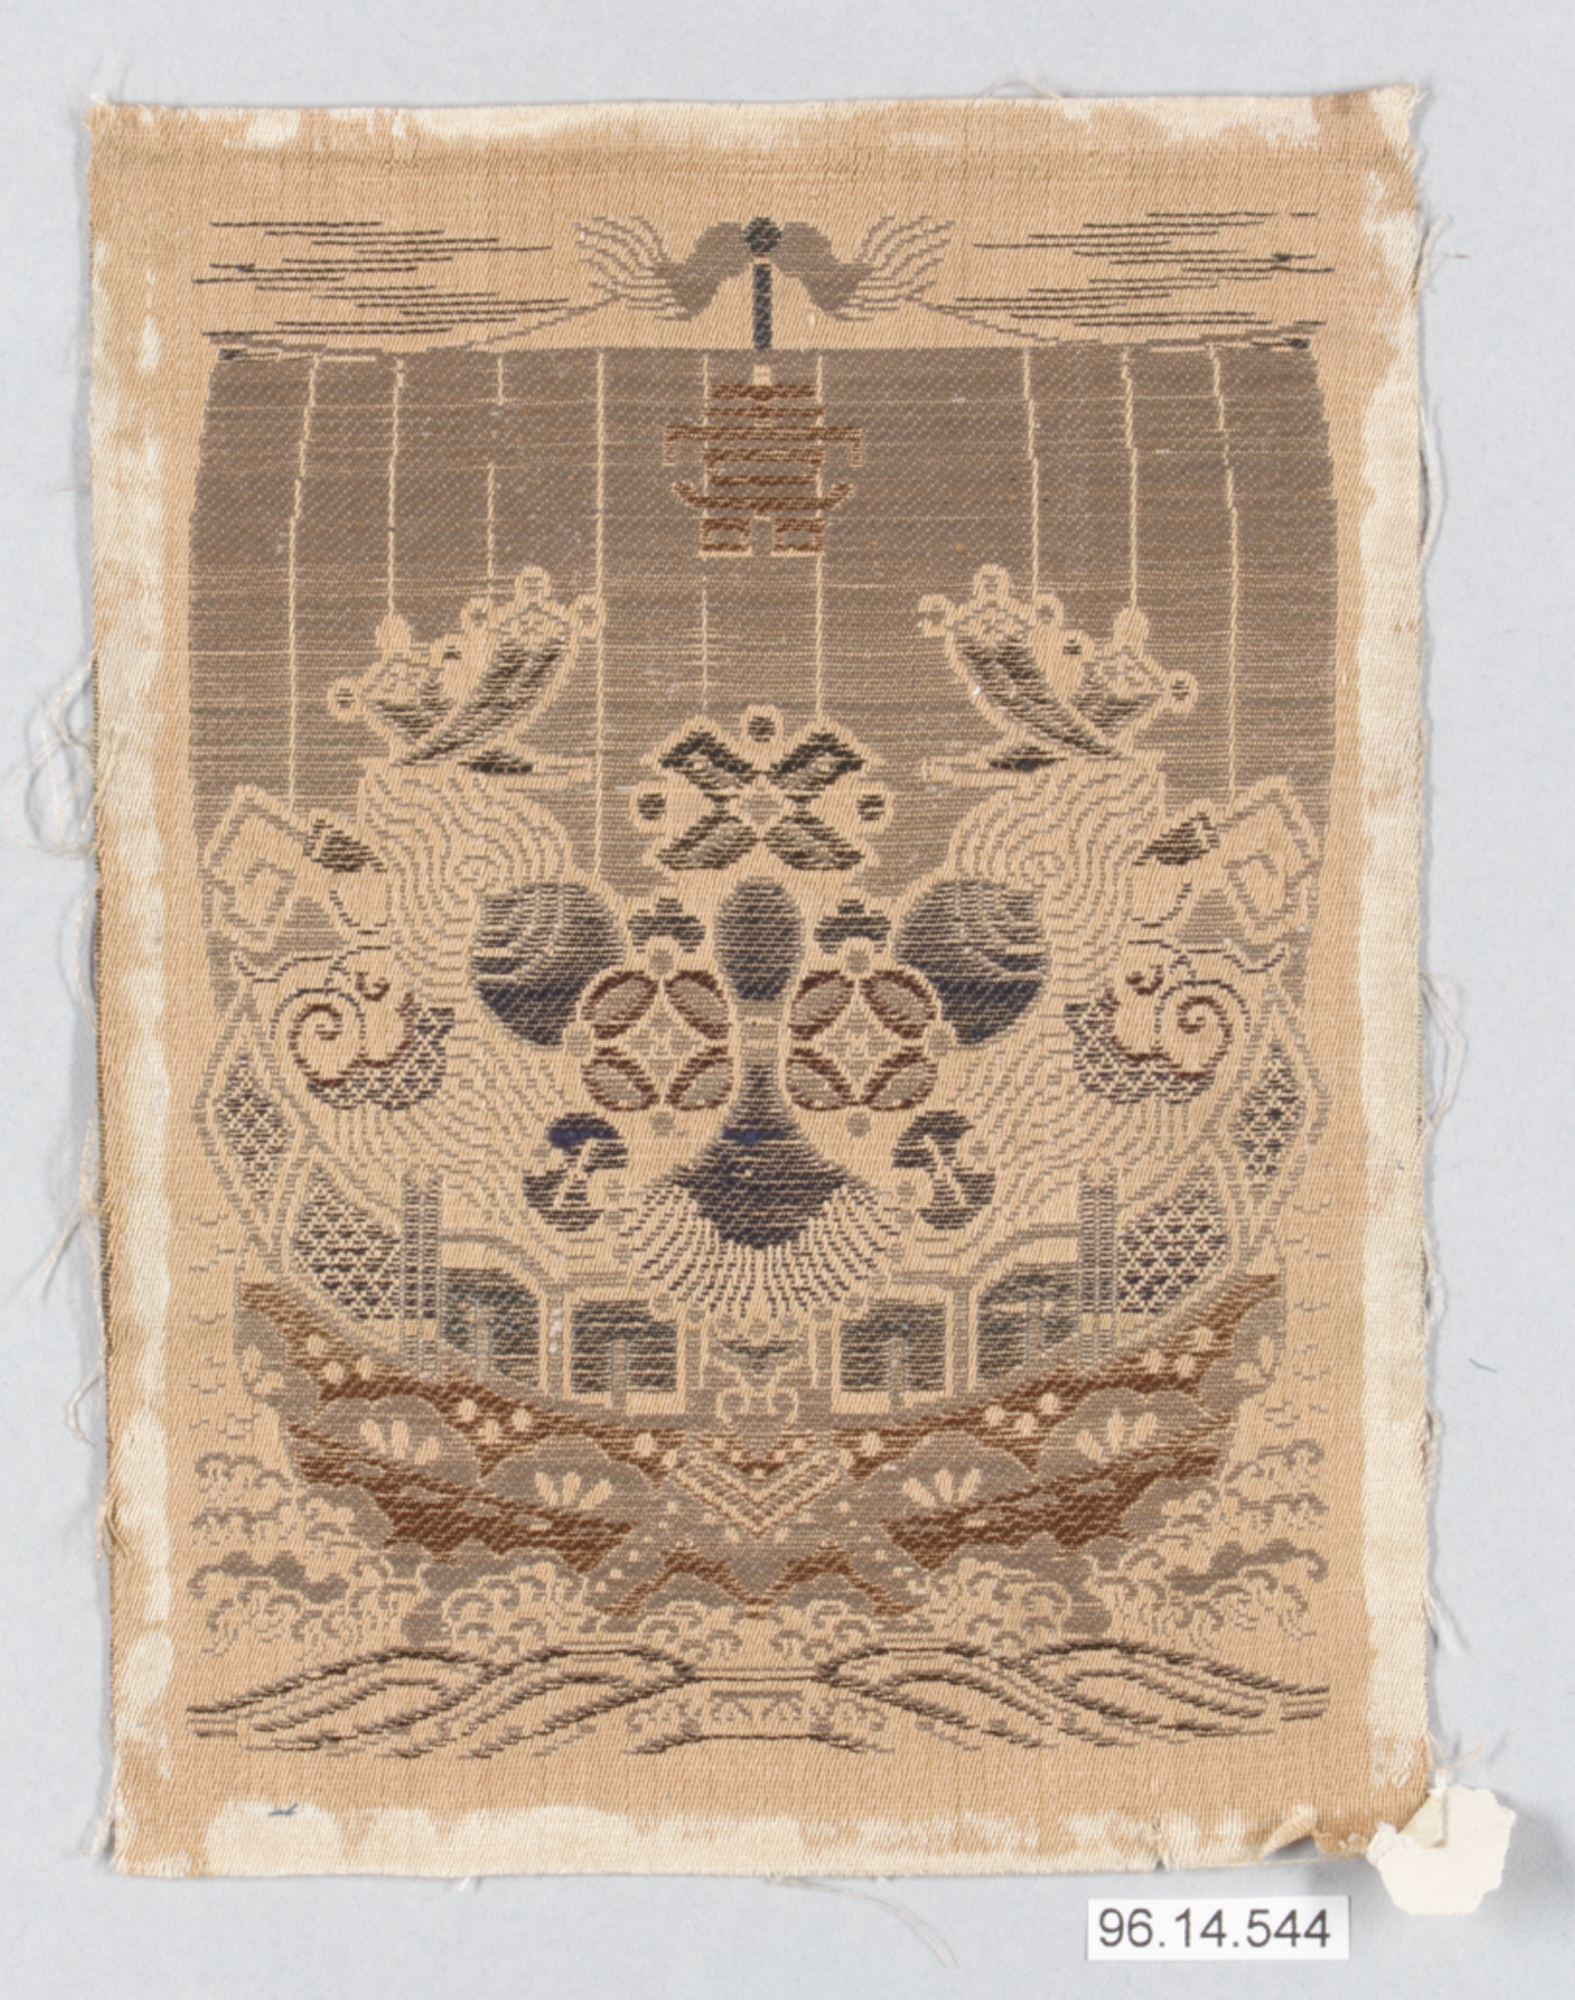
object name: piece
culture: japanese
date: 1701-1900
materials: silk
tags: ships